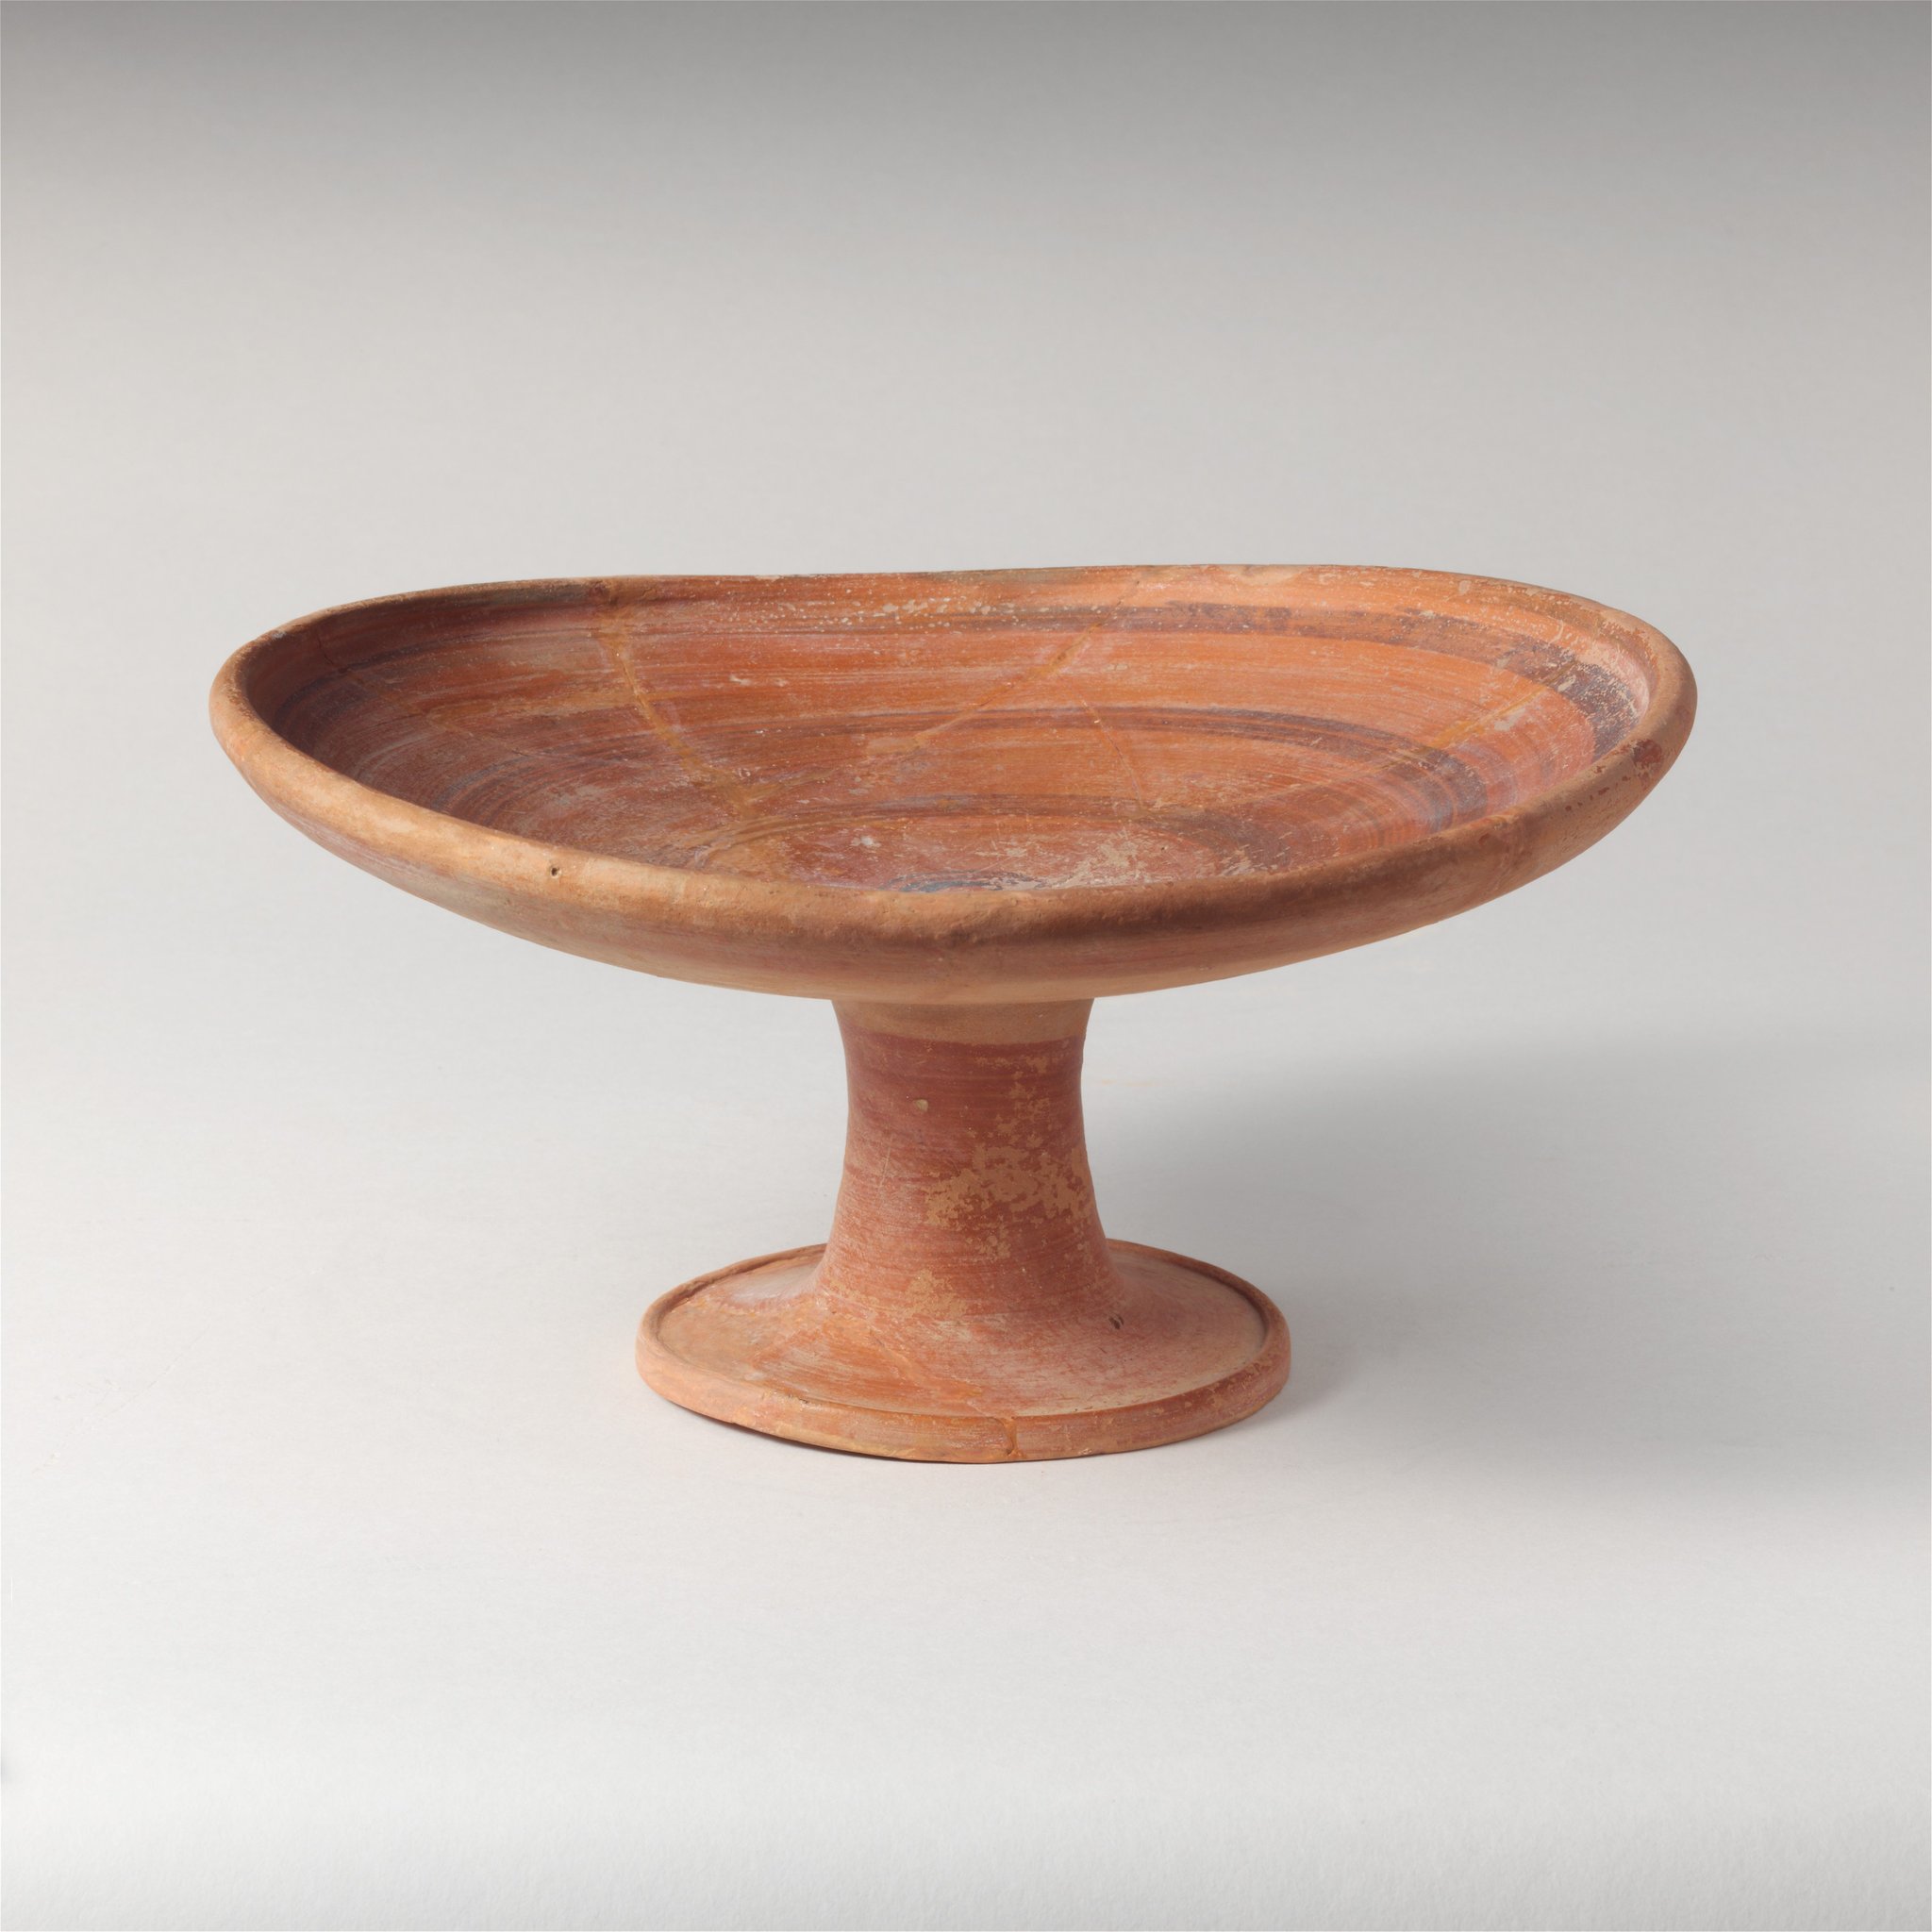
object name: bowl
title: Terracotta stemmed dish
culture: lydian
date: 600-501 BCE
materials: terracotta